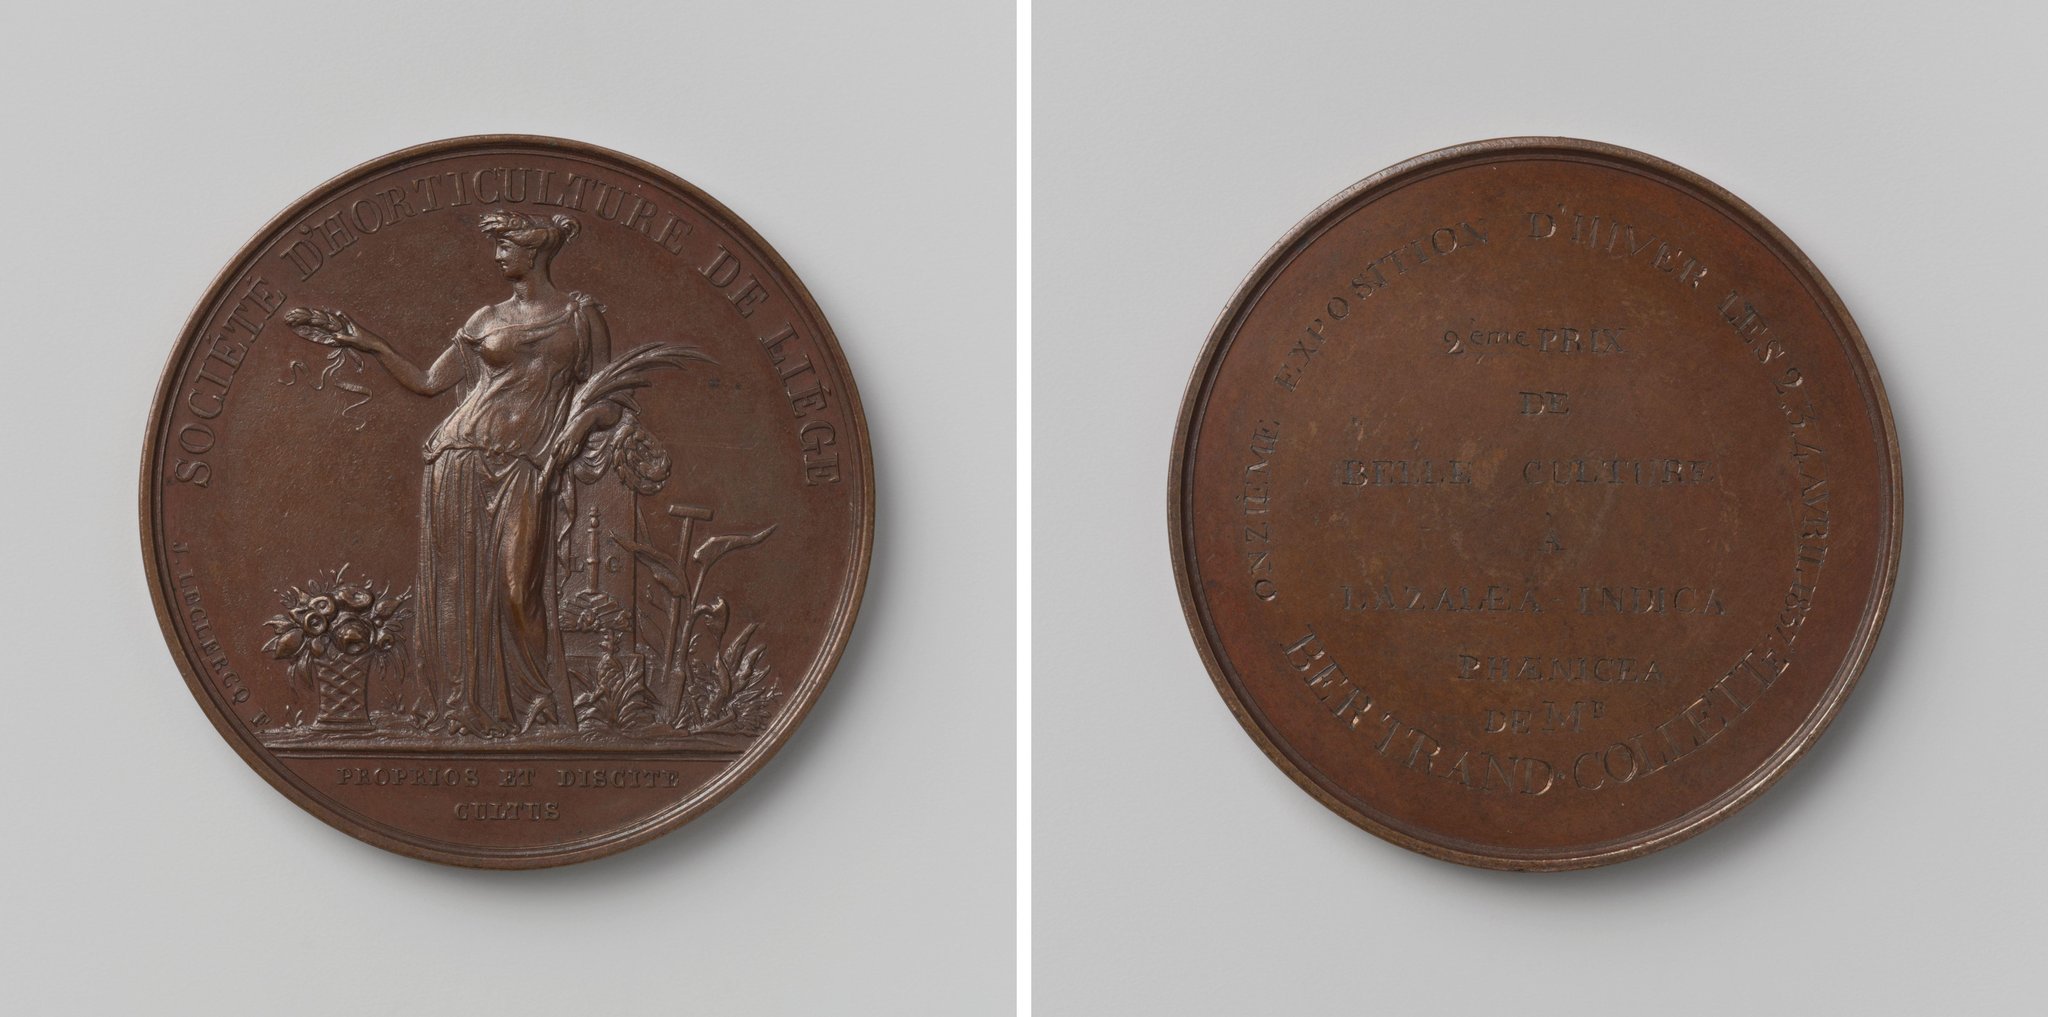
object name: medal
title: Elfde wintertentoonstelling van de Societe d'Horticulture te Luik, penning als tweede prijs uitgereikt aan Bertrand Collette voor een azalea indica phaenica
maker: julien gabriel leclercq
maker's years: 1805-1882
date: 1837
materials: bronze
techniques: engraving, striking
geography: brussels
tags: liège